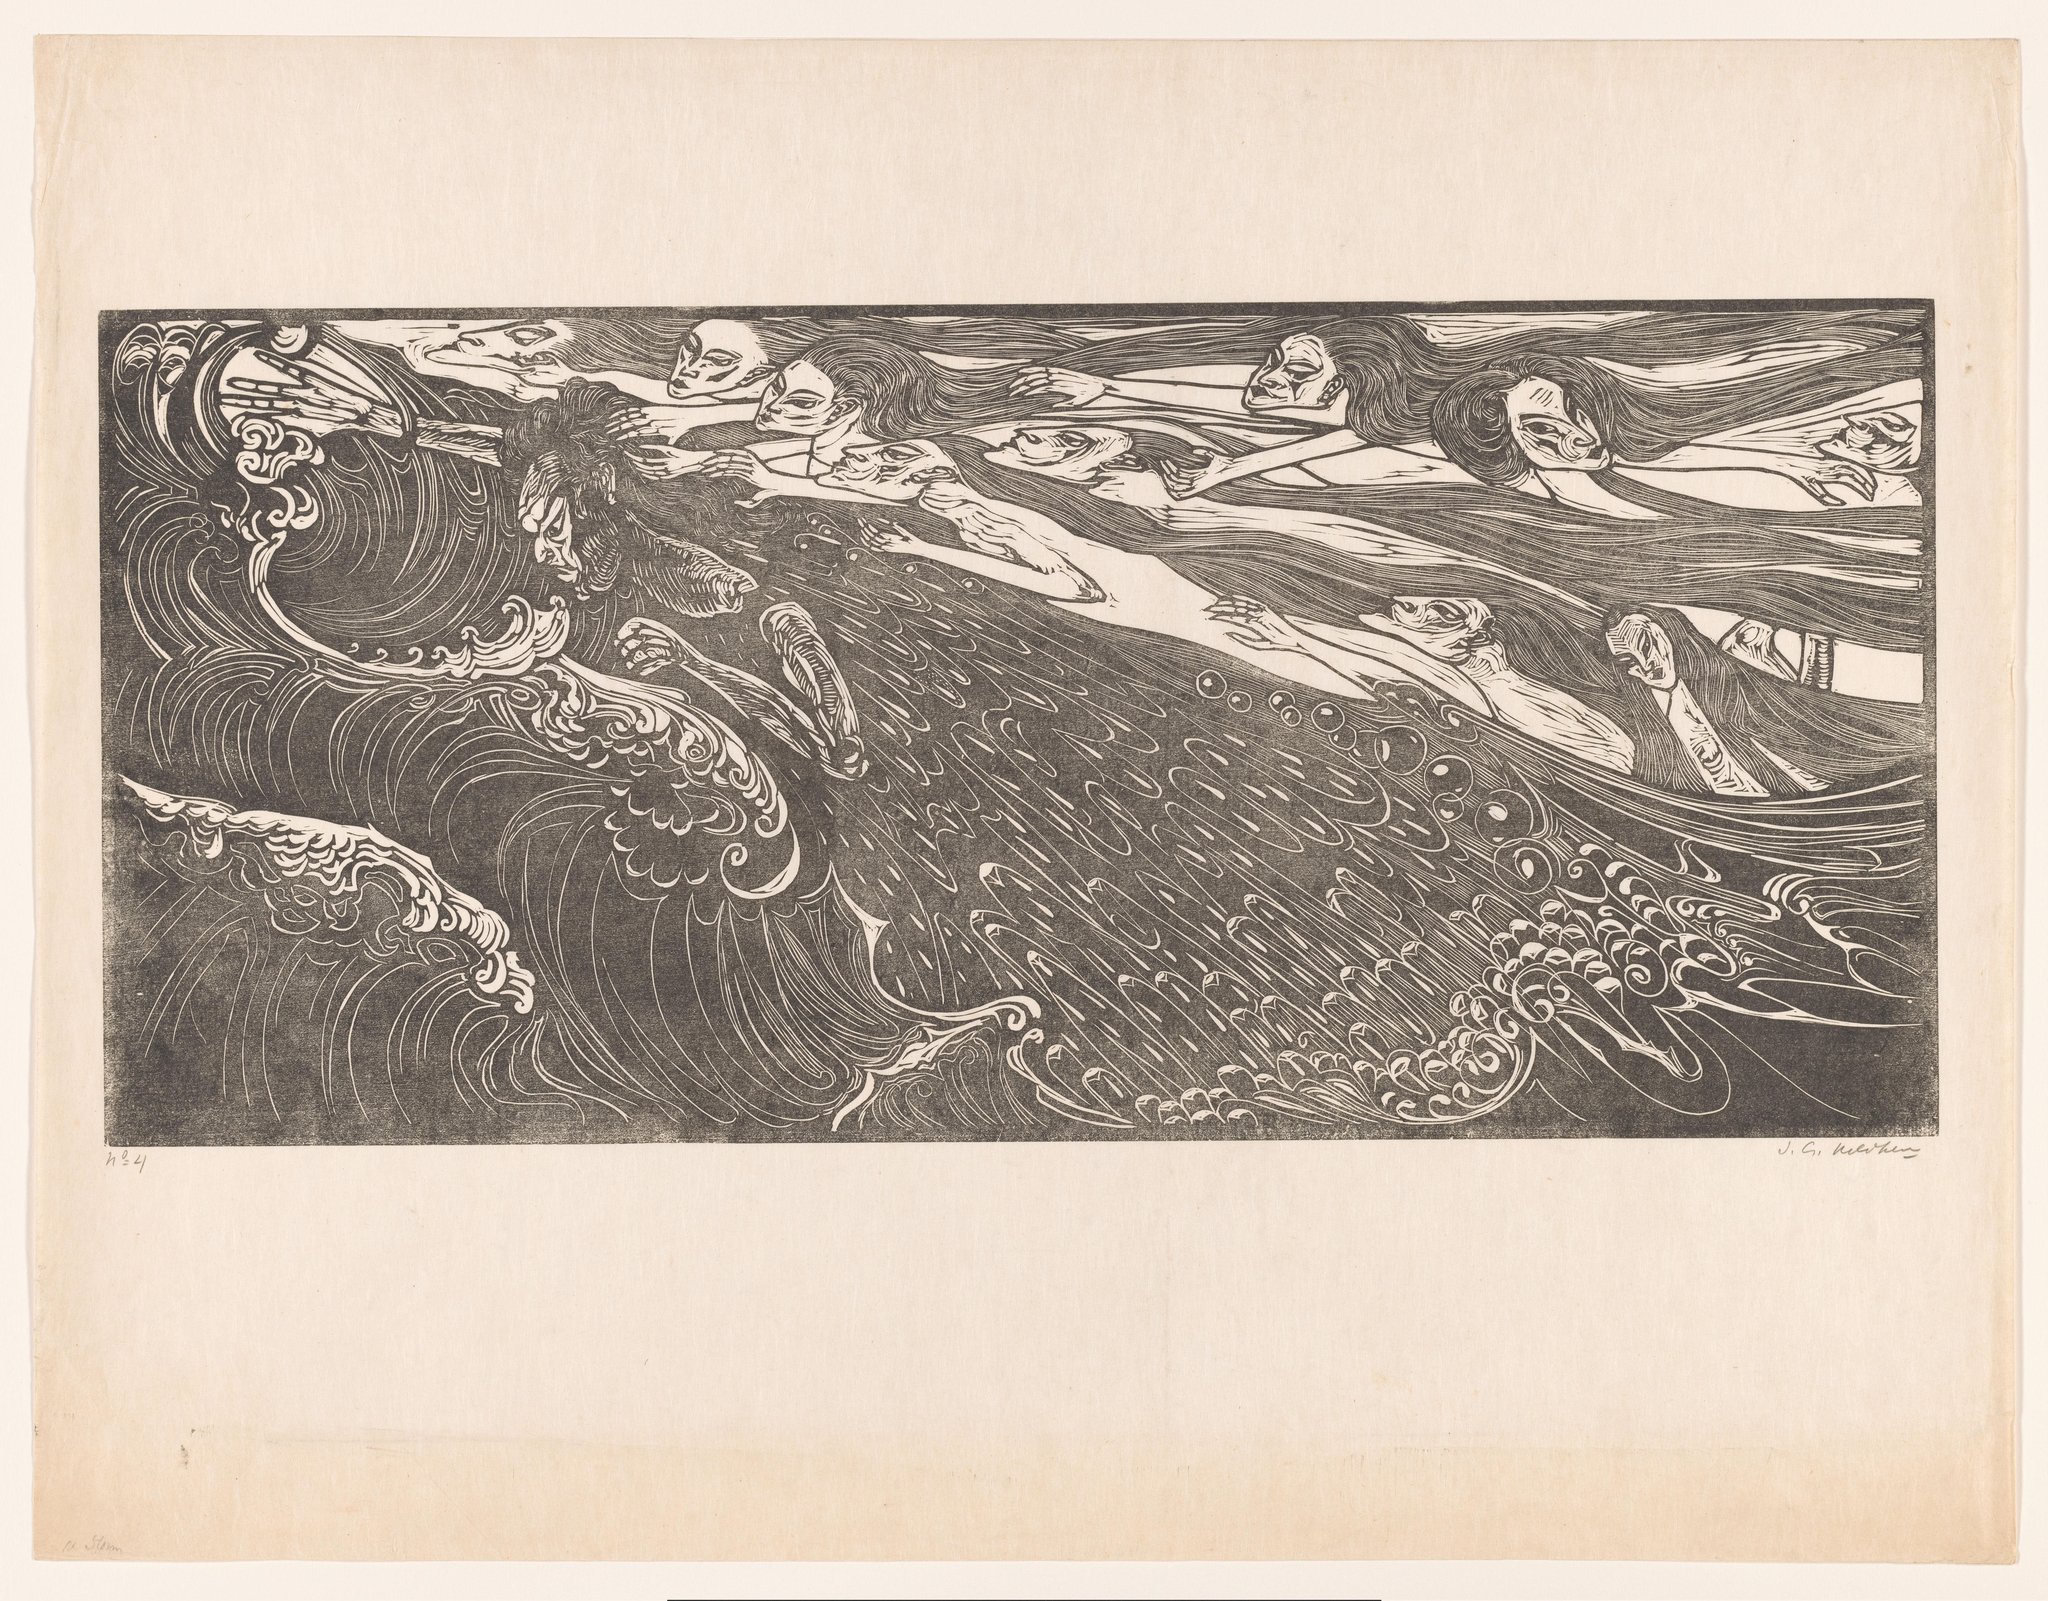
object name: print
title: De storm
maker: jacobus gerardus veldheer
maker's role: draughtsman, print maker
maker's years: 1866-1954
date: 1876-1916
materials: paper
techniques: woodcut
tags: wave, storm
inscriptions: collector's mark: Lugt 2233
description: Figuren in de lucht boven een zee met hoge golven.